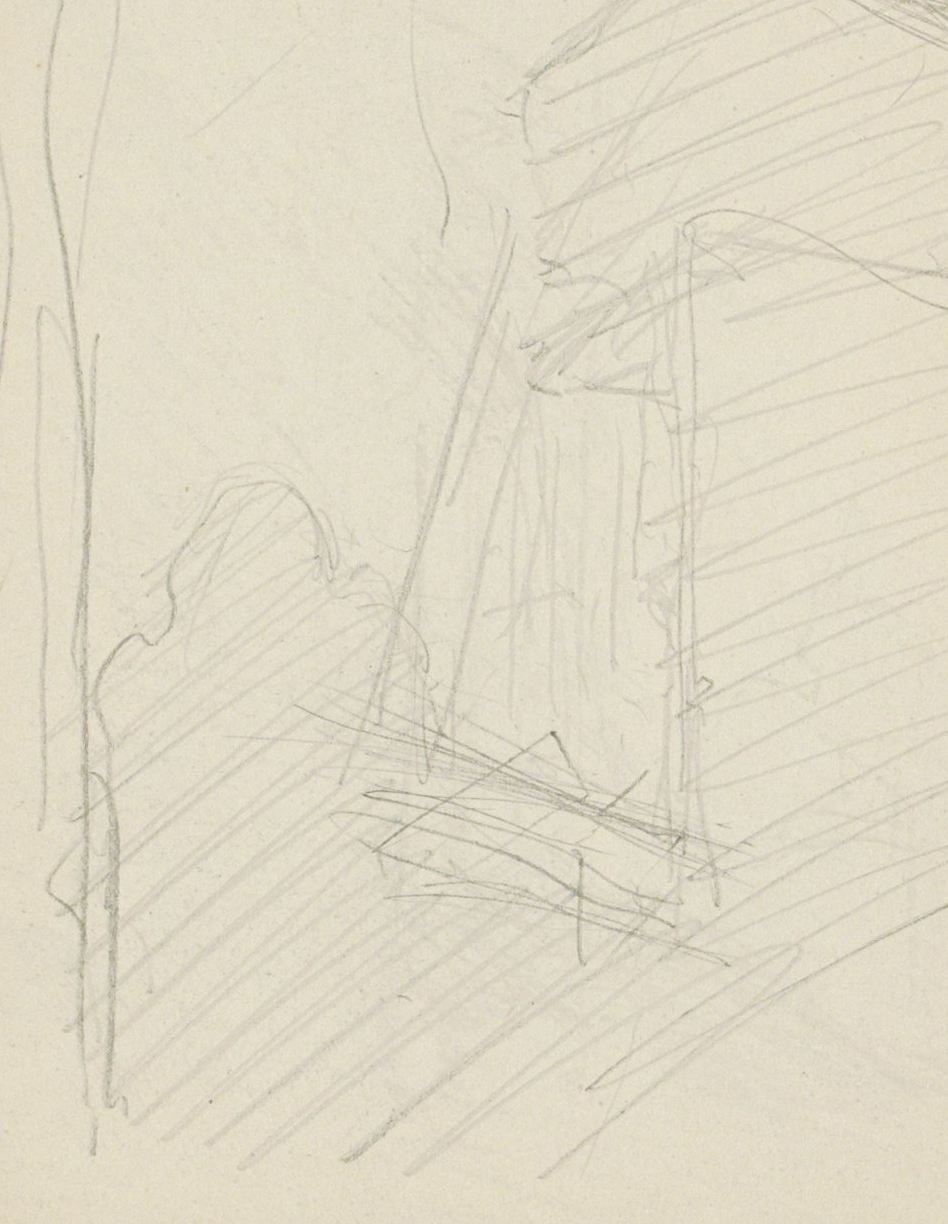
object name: sketchbook leaf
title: Toren in de steigers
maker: reijer stolk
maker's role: draughtsman, print maker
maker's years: 1896-1945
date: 1906-1945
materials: paper, pencil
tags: scaffold (~ building activities), tower (of house or building)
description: Blad 59 verso uit een schetsboek met 69 bladen.